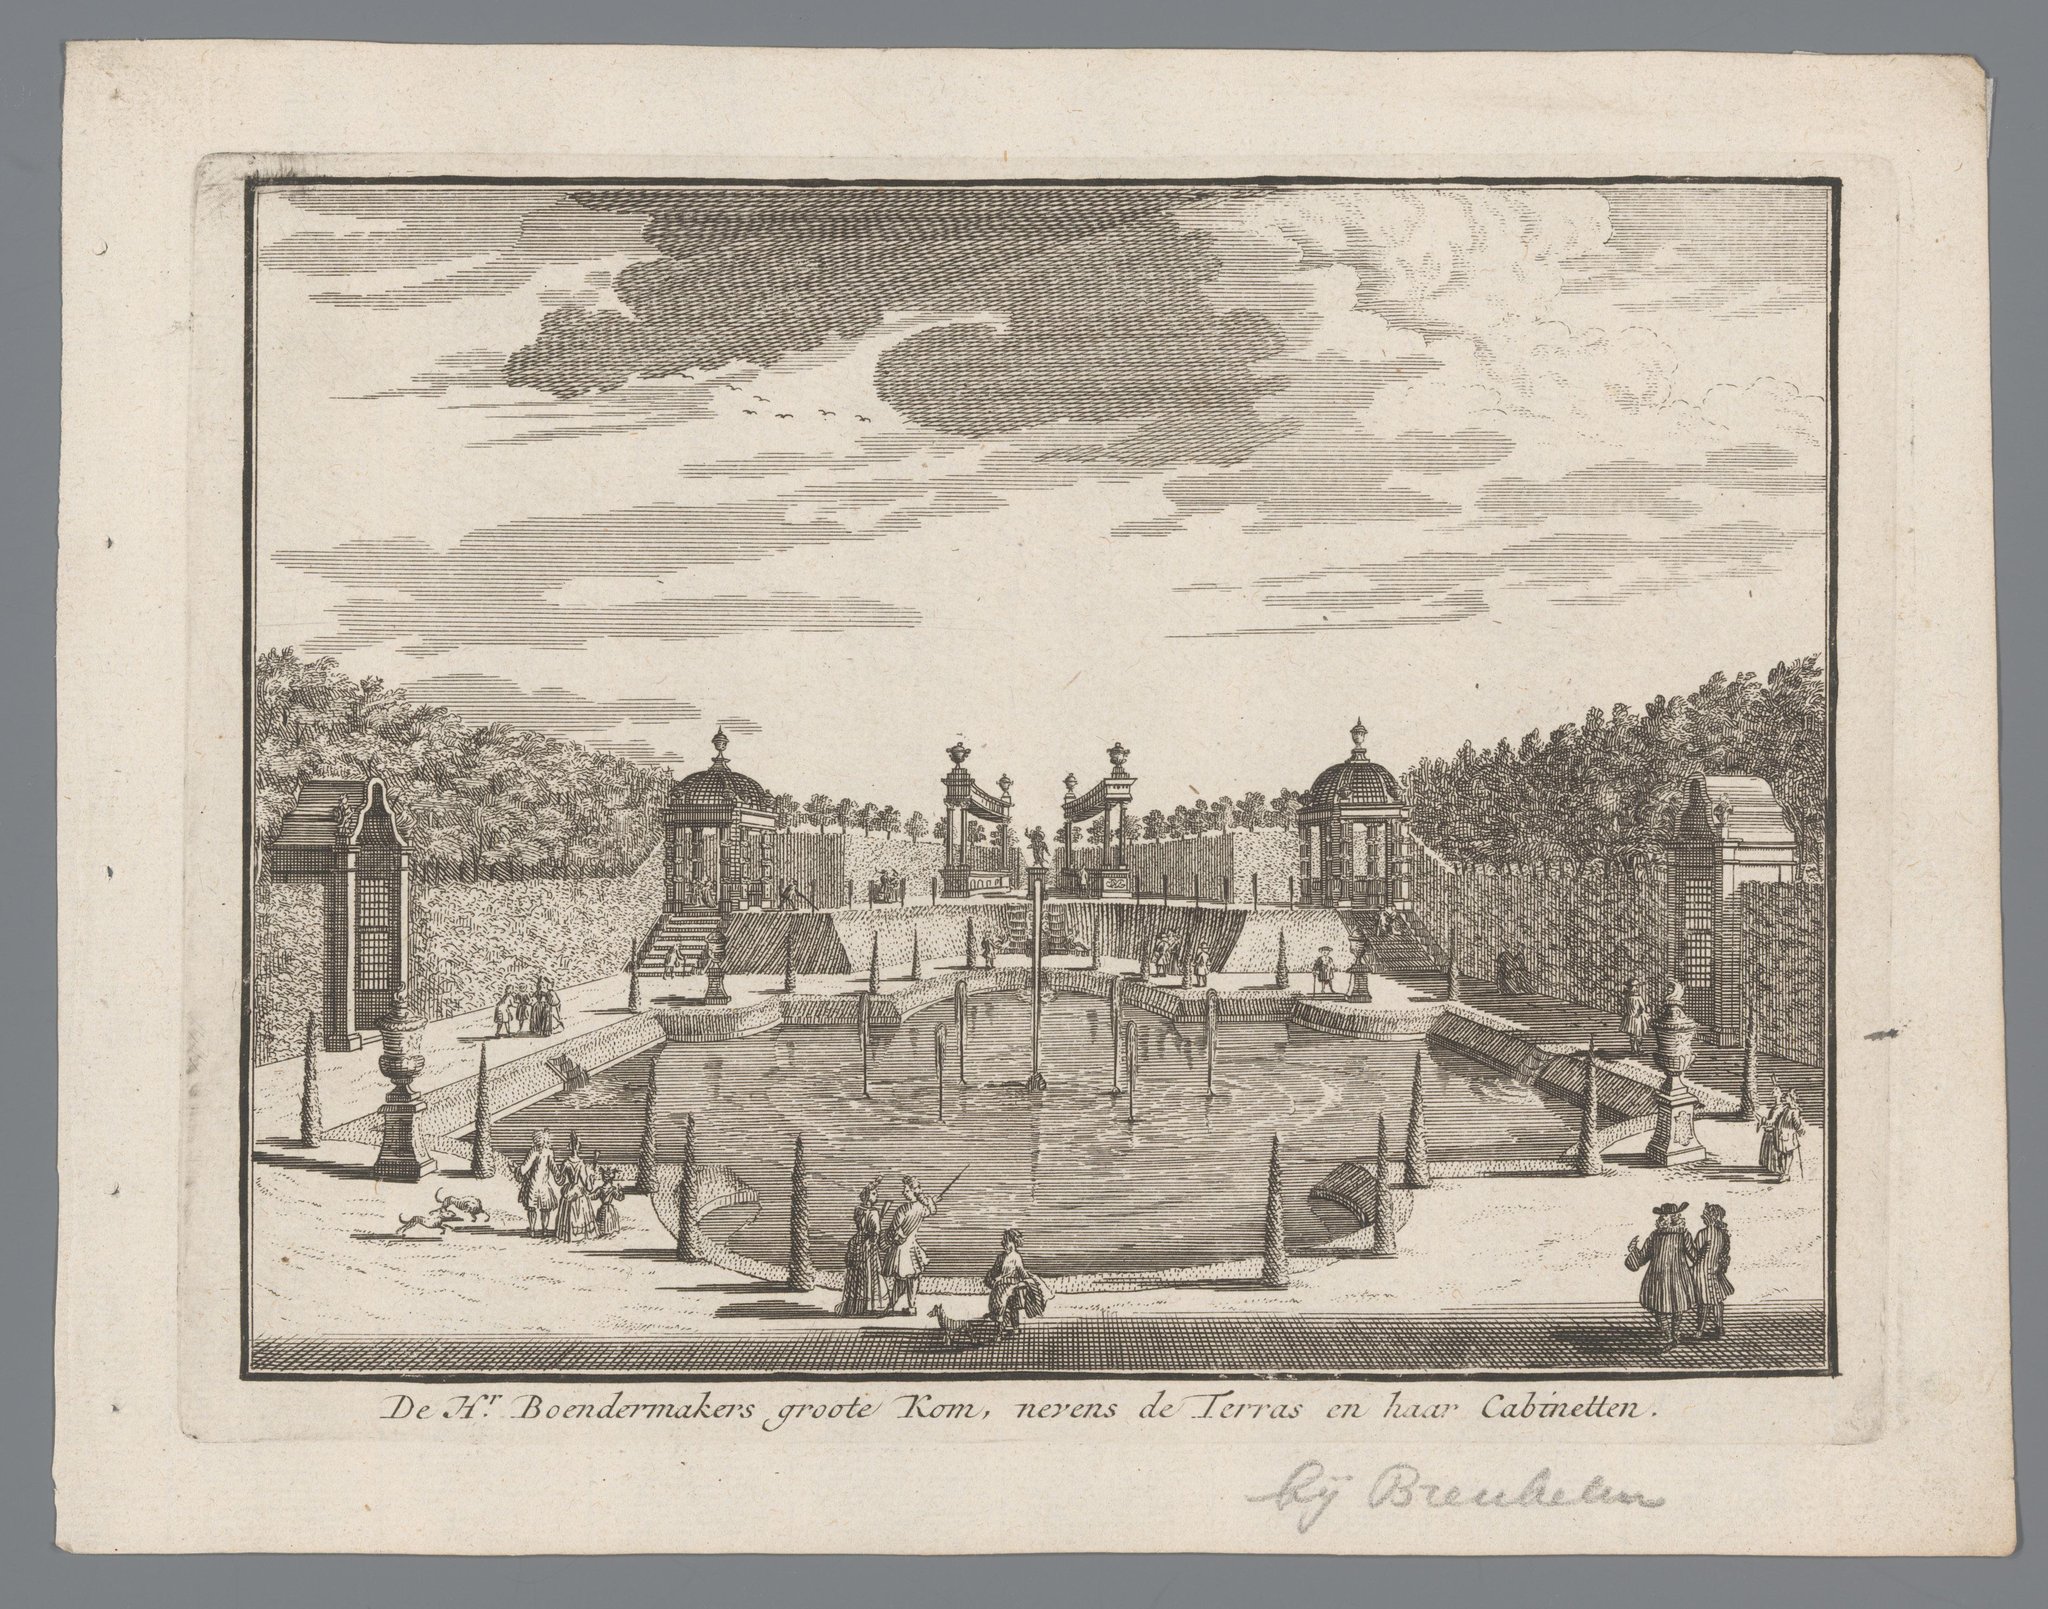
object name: print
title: Gezicht op de tuin van de buitenplaats van de heer Boendermaker bij Breukelen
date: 1719-1757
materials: paper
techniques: etching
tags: rural housing, e.g. country-house, villa, cottage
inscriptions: collector's mark: Lugt 2228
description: Kopie naar de prent in: Stopendaal, Daniël. De zegepraalende Vecht, vertoonende verscheidenen gesichten van lustplaatsen, heeren huysen en dorpen, beginnende van Uitrecht en met Muyden besluytende. Amsterdam: Weduwe Nicolaas Visscher, 1719.